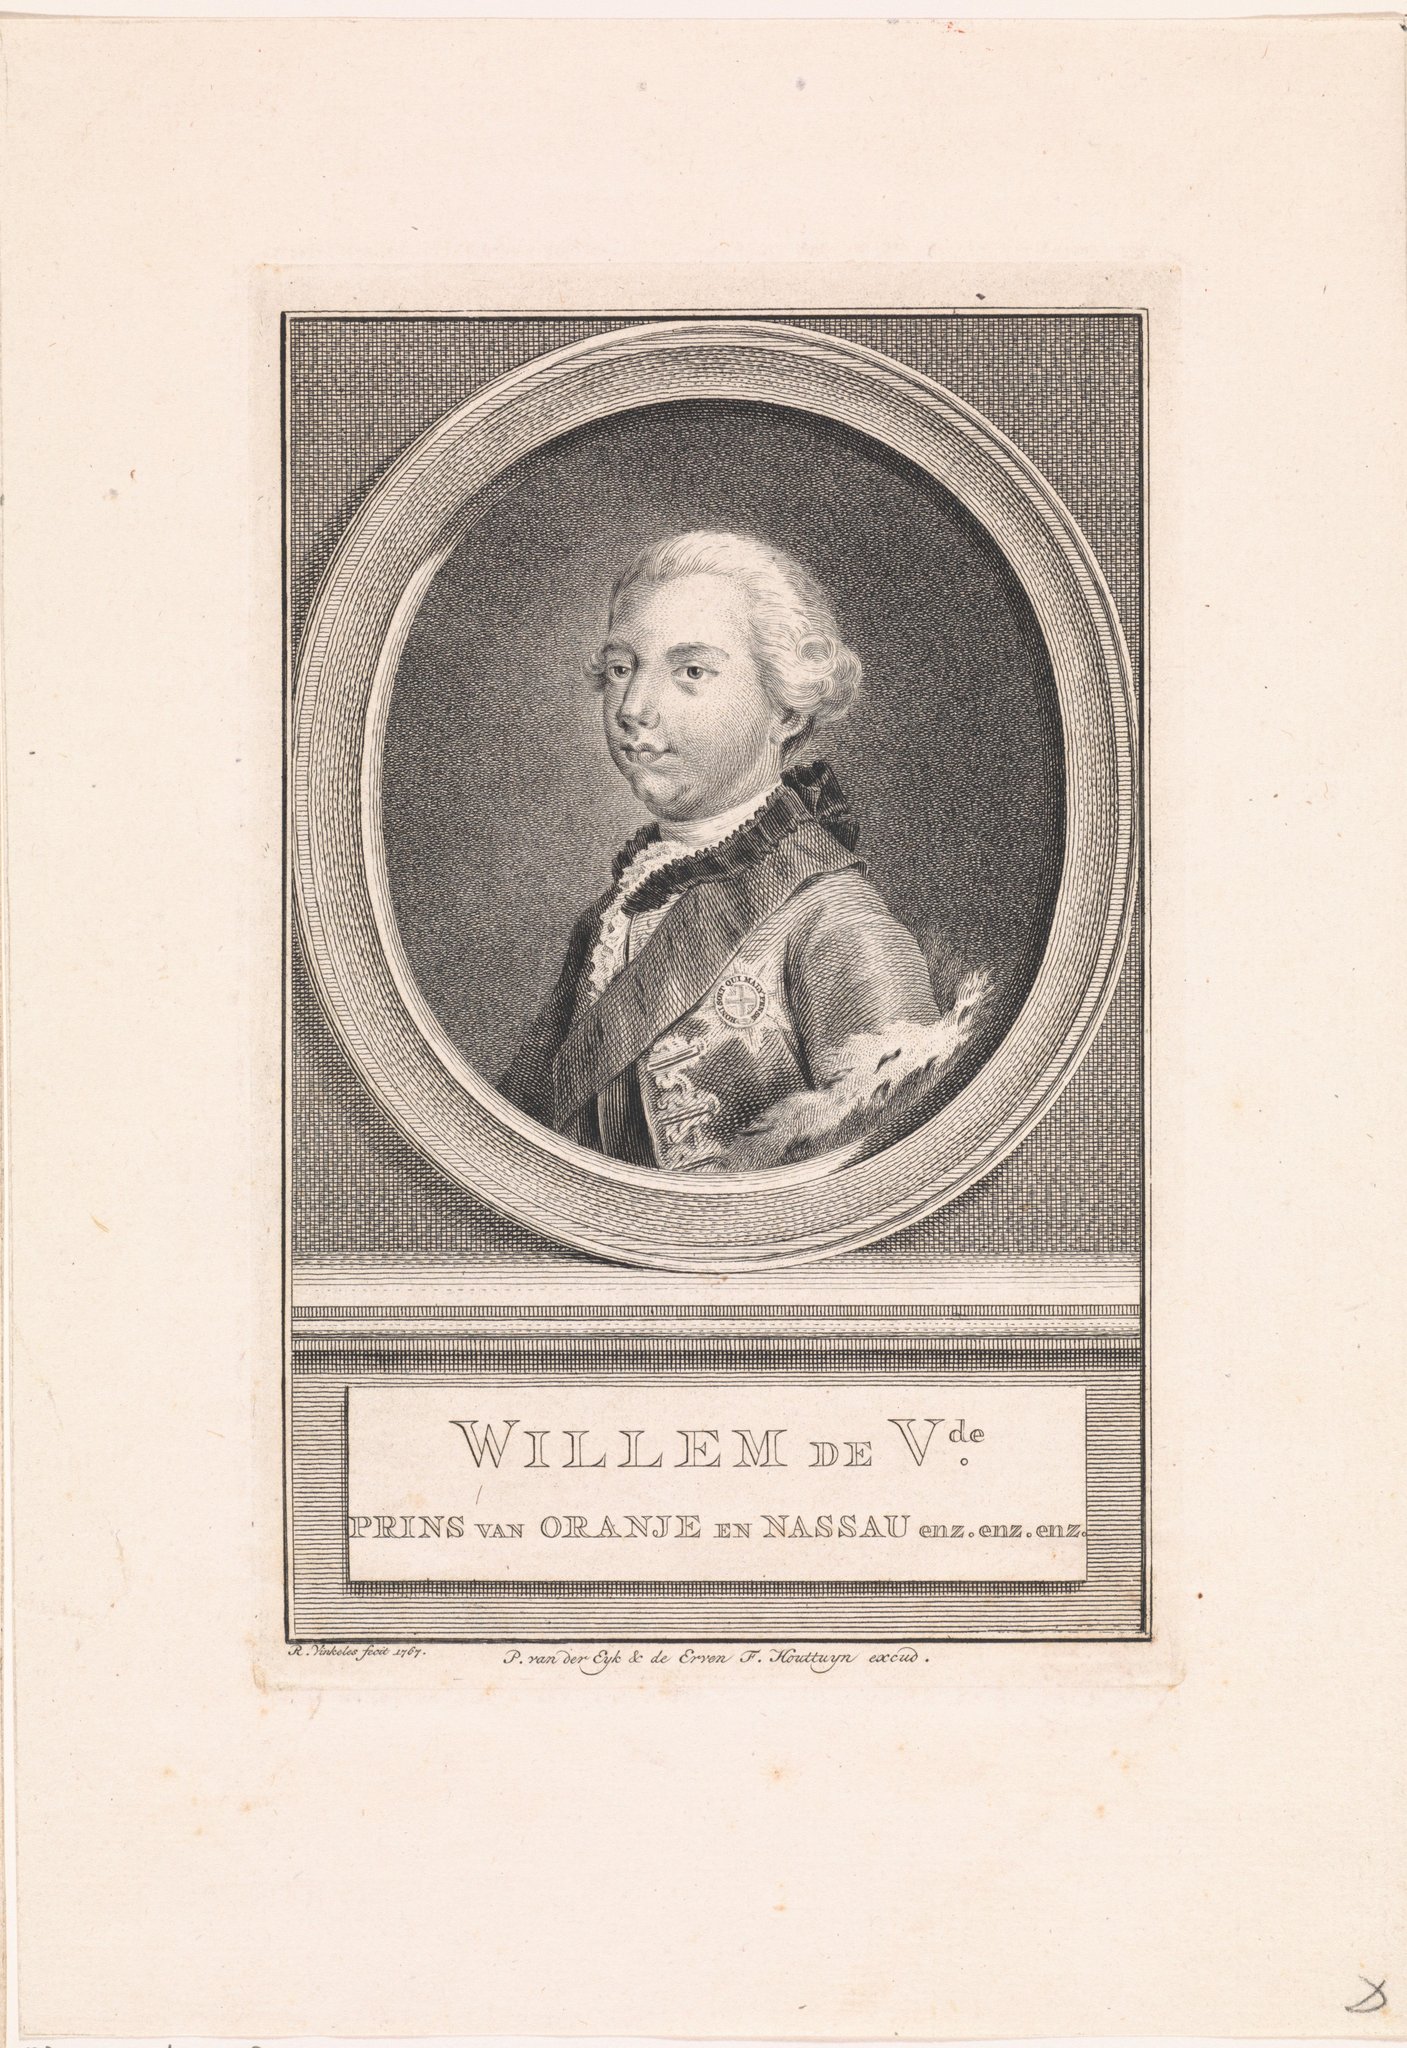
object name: print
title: Portret van Willem V, prins van Oranje-Nassau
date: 1767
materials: paper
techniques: engraving, etching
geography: amsterdam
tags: the hague, william v (prince of orange)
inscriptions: collector's mark: Lugt 240